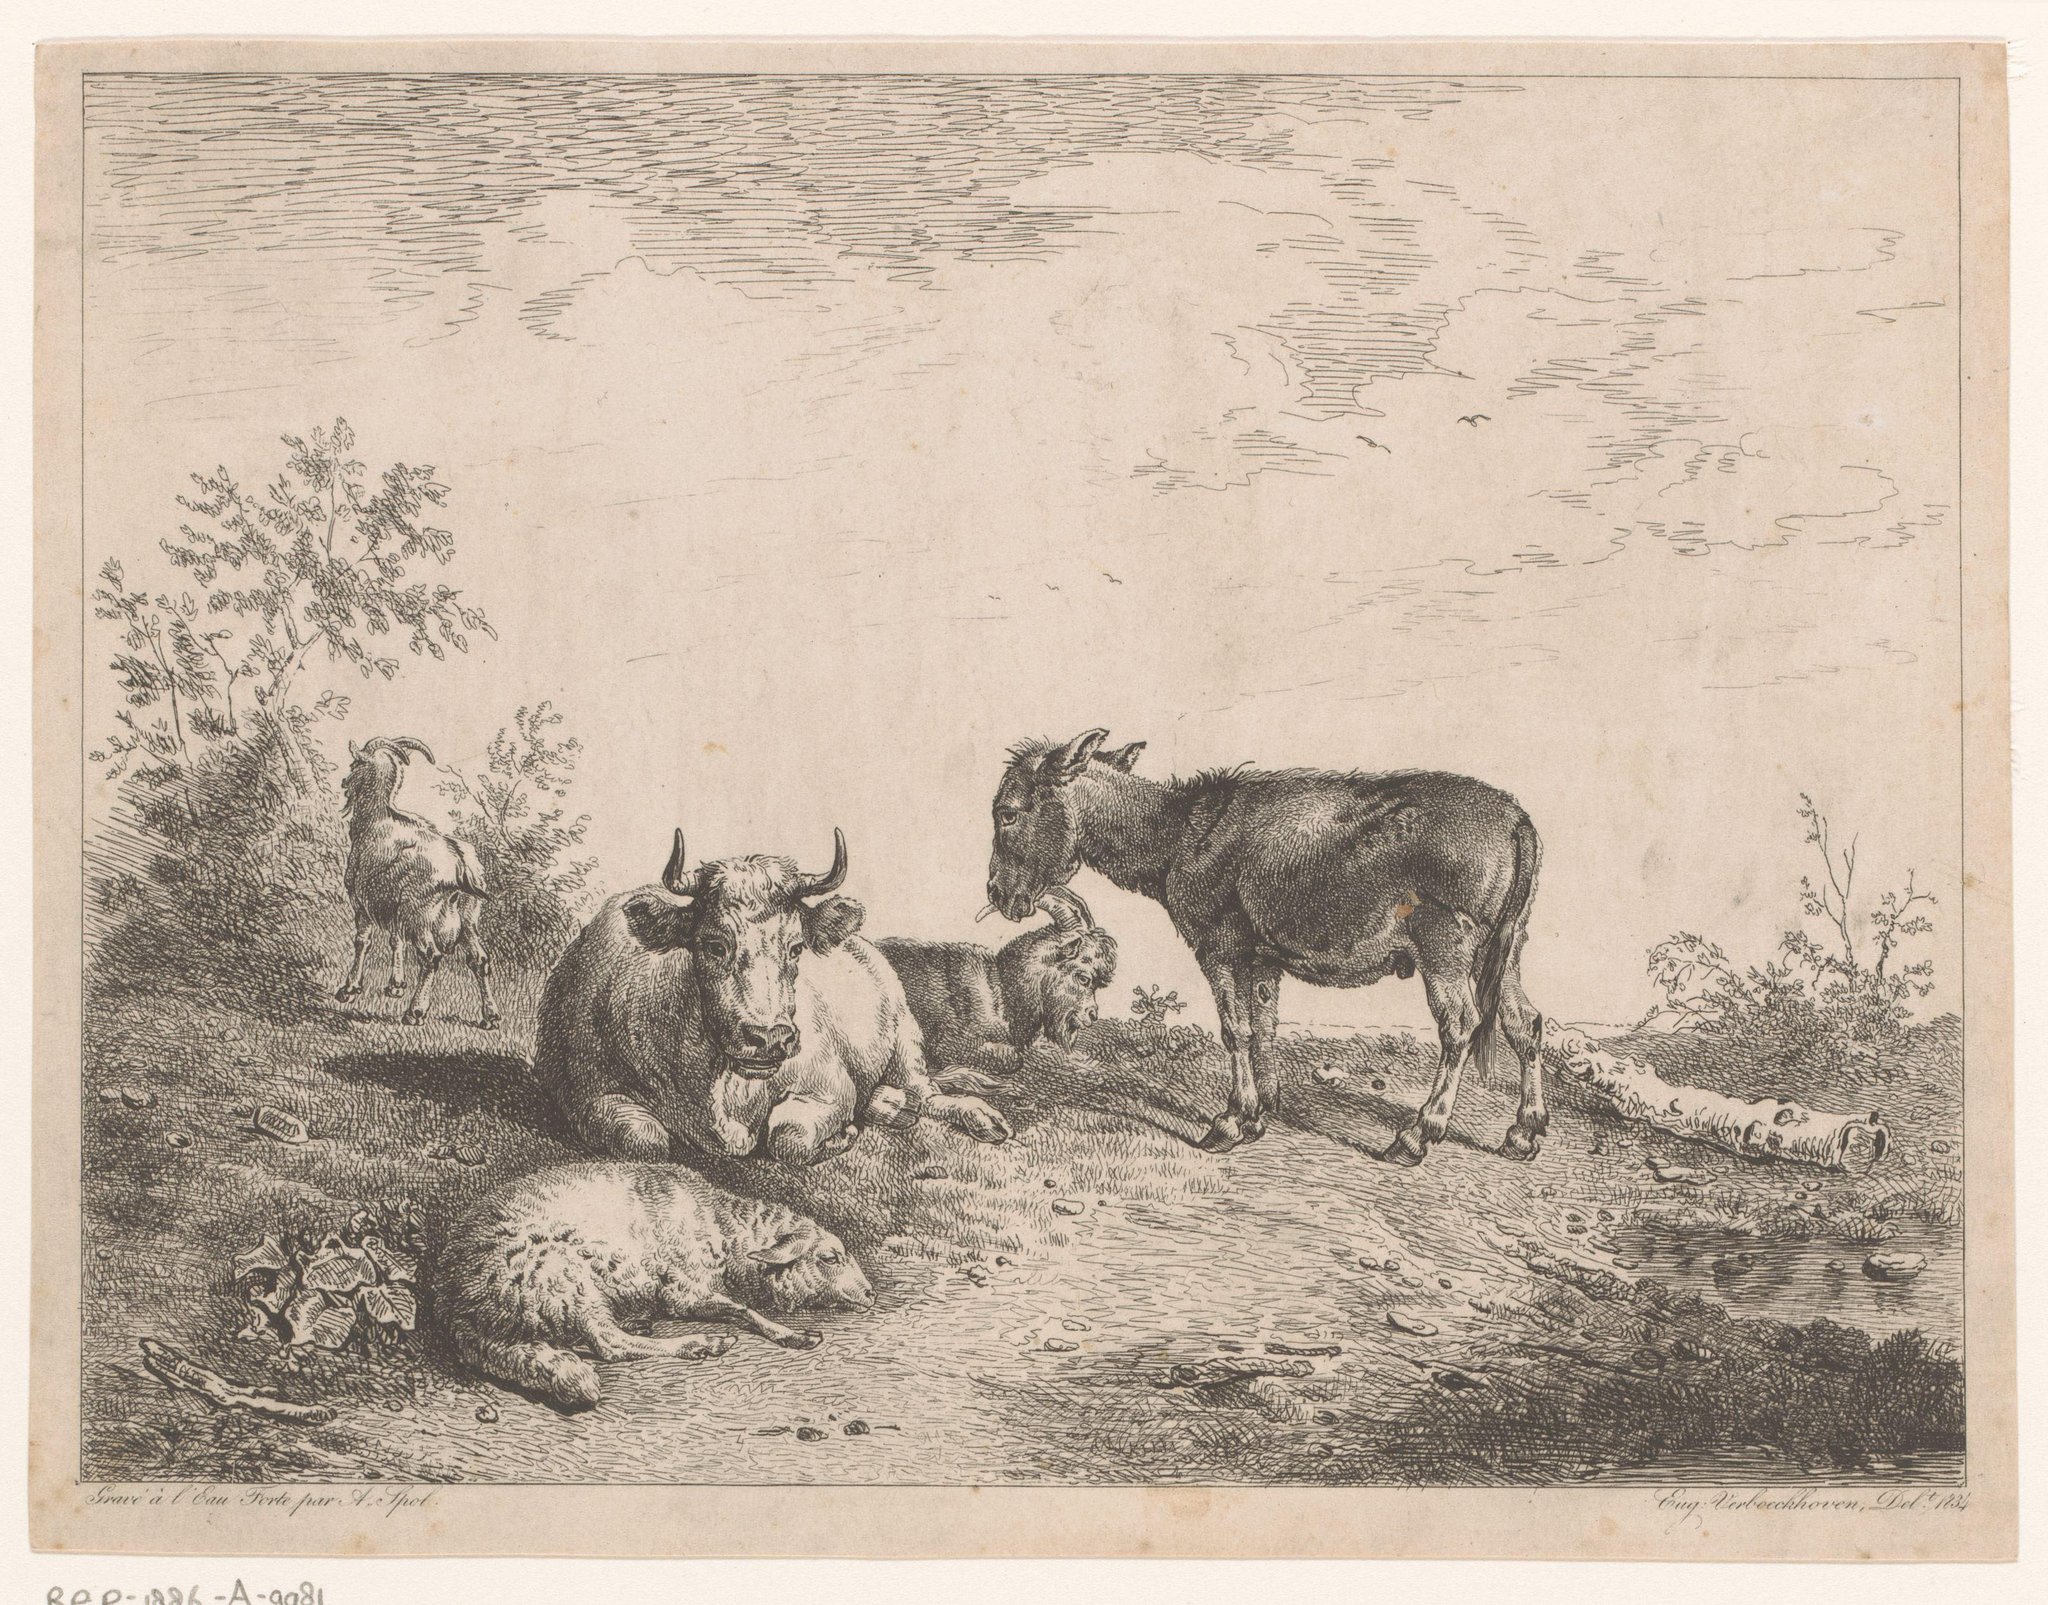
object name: print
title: Landschap met vee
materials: paper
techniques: etching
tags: landscapes, cattle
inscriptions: collector's mark: Lugt 2228